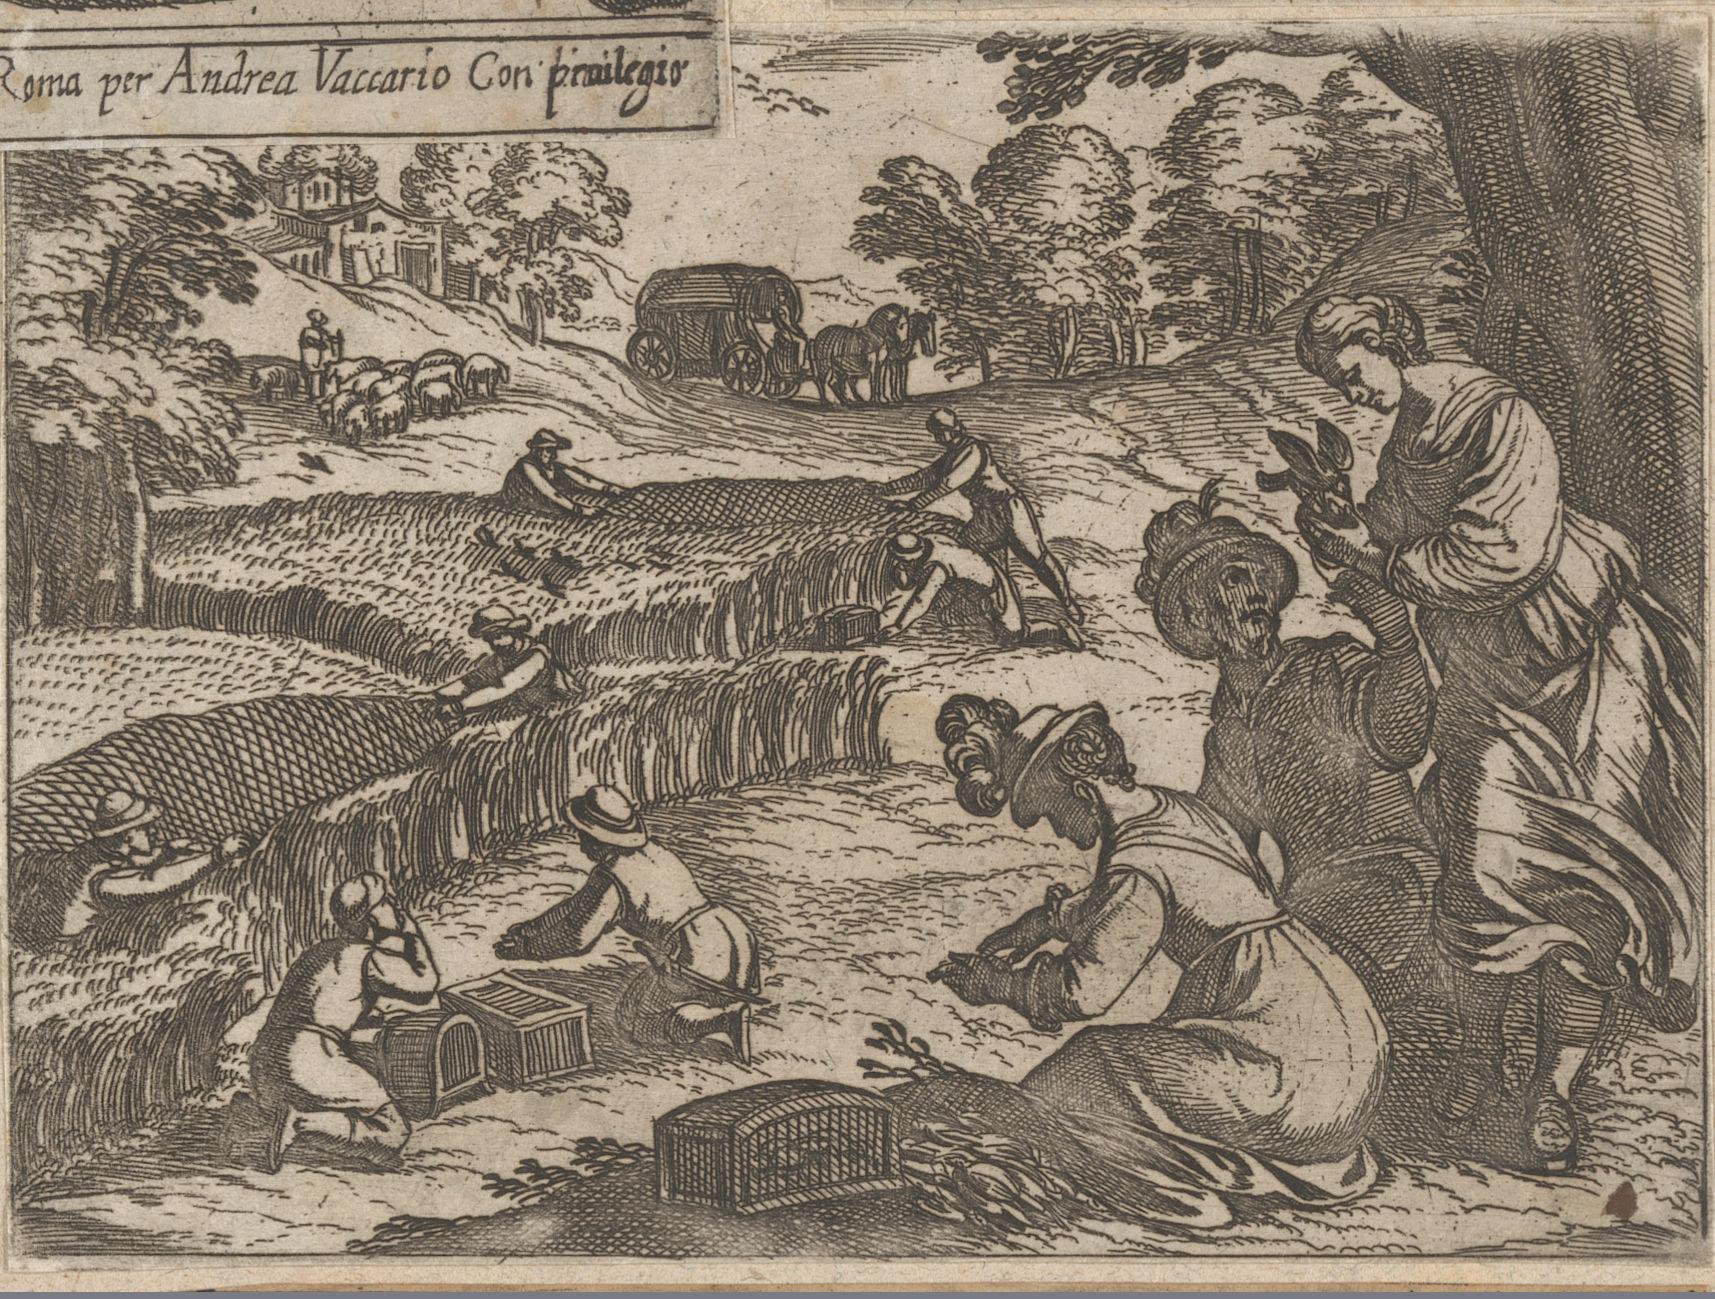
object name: print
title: Jachtscènes (deel 2)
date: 1598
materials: paper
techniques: etching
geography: vatican city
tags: hunter, hunters hunting (n.b.: in 1988-1990 this notation denoted the concept of 43c11421 'hunters resting during the hunt'), bird hunting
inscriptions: number: ‘4’, collector's mark: ‘Hinloopen’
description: Landschap met jagers die met behulp van netten en kooien kleine vogels in het hoge gras vangen. Op de voorgrond een man en twee vrouwen met de gevangen vogels.